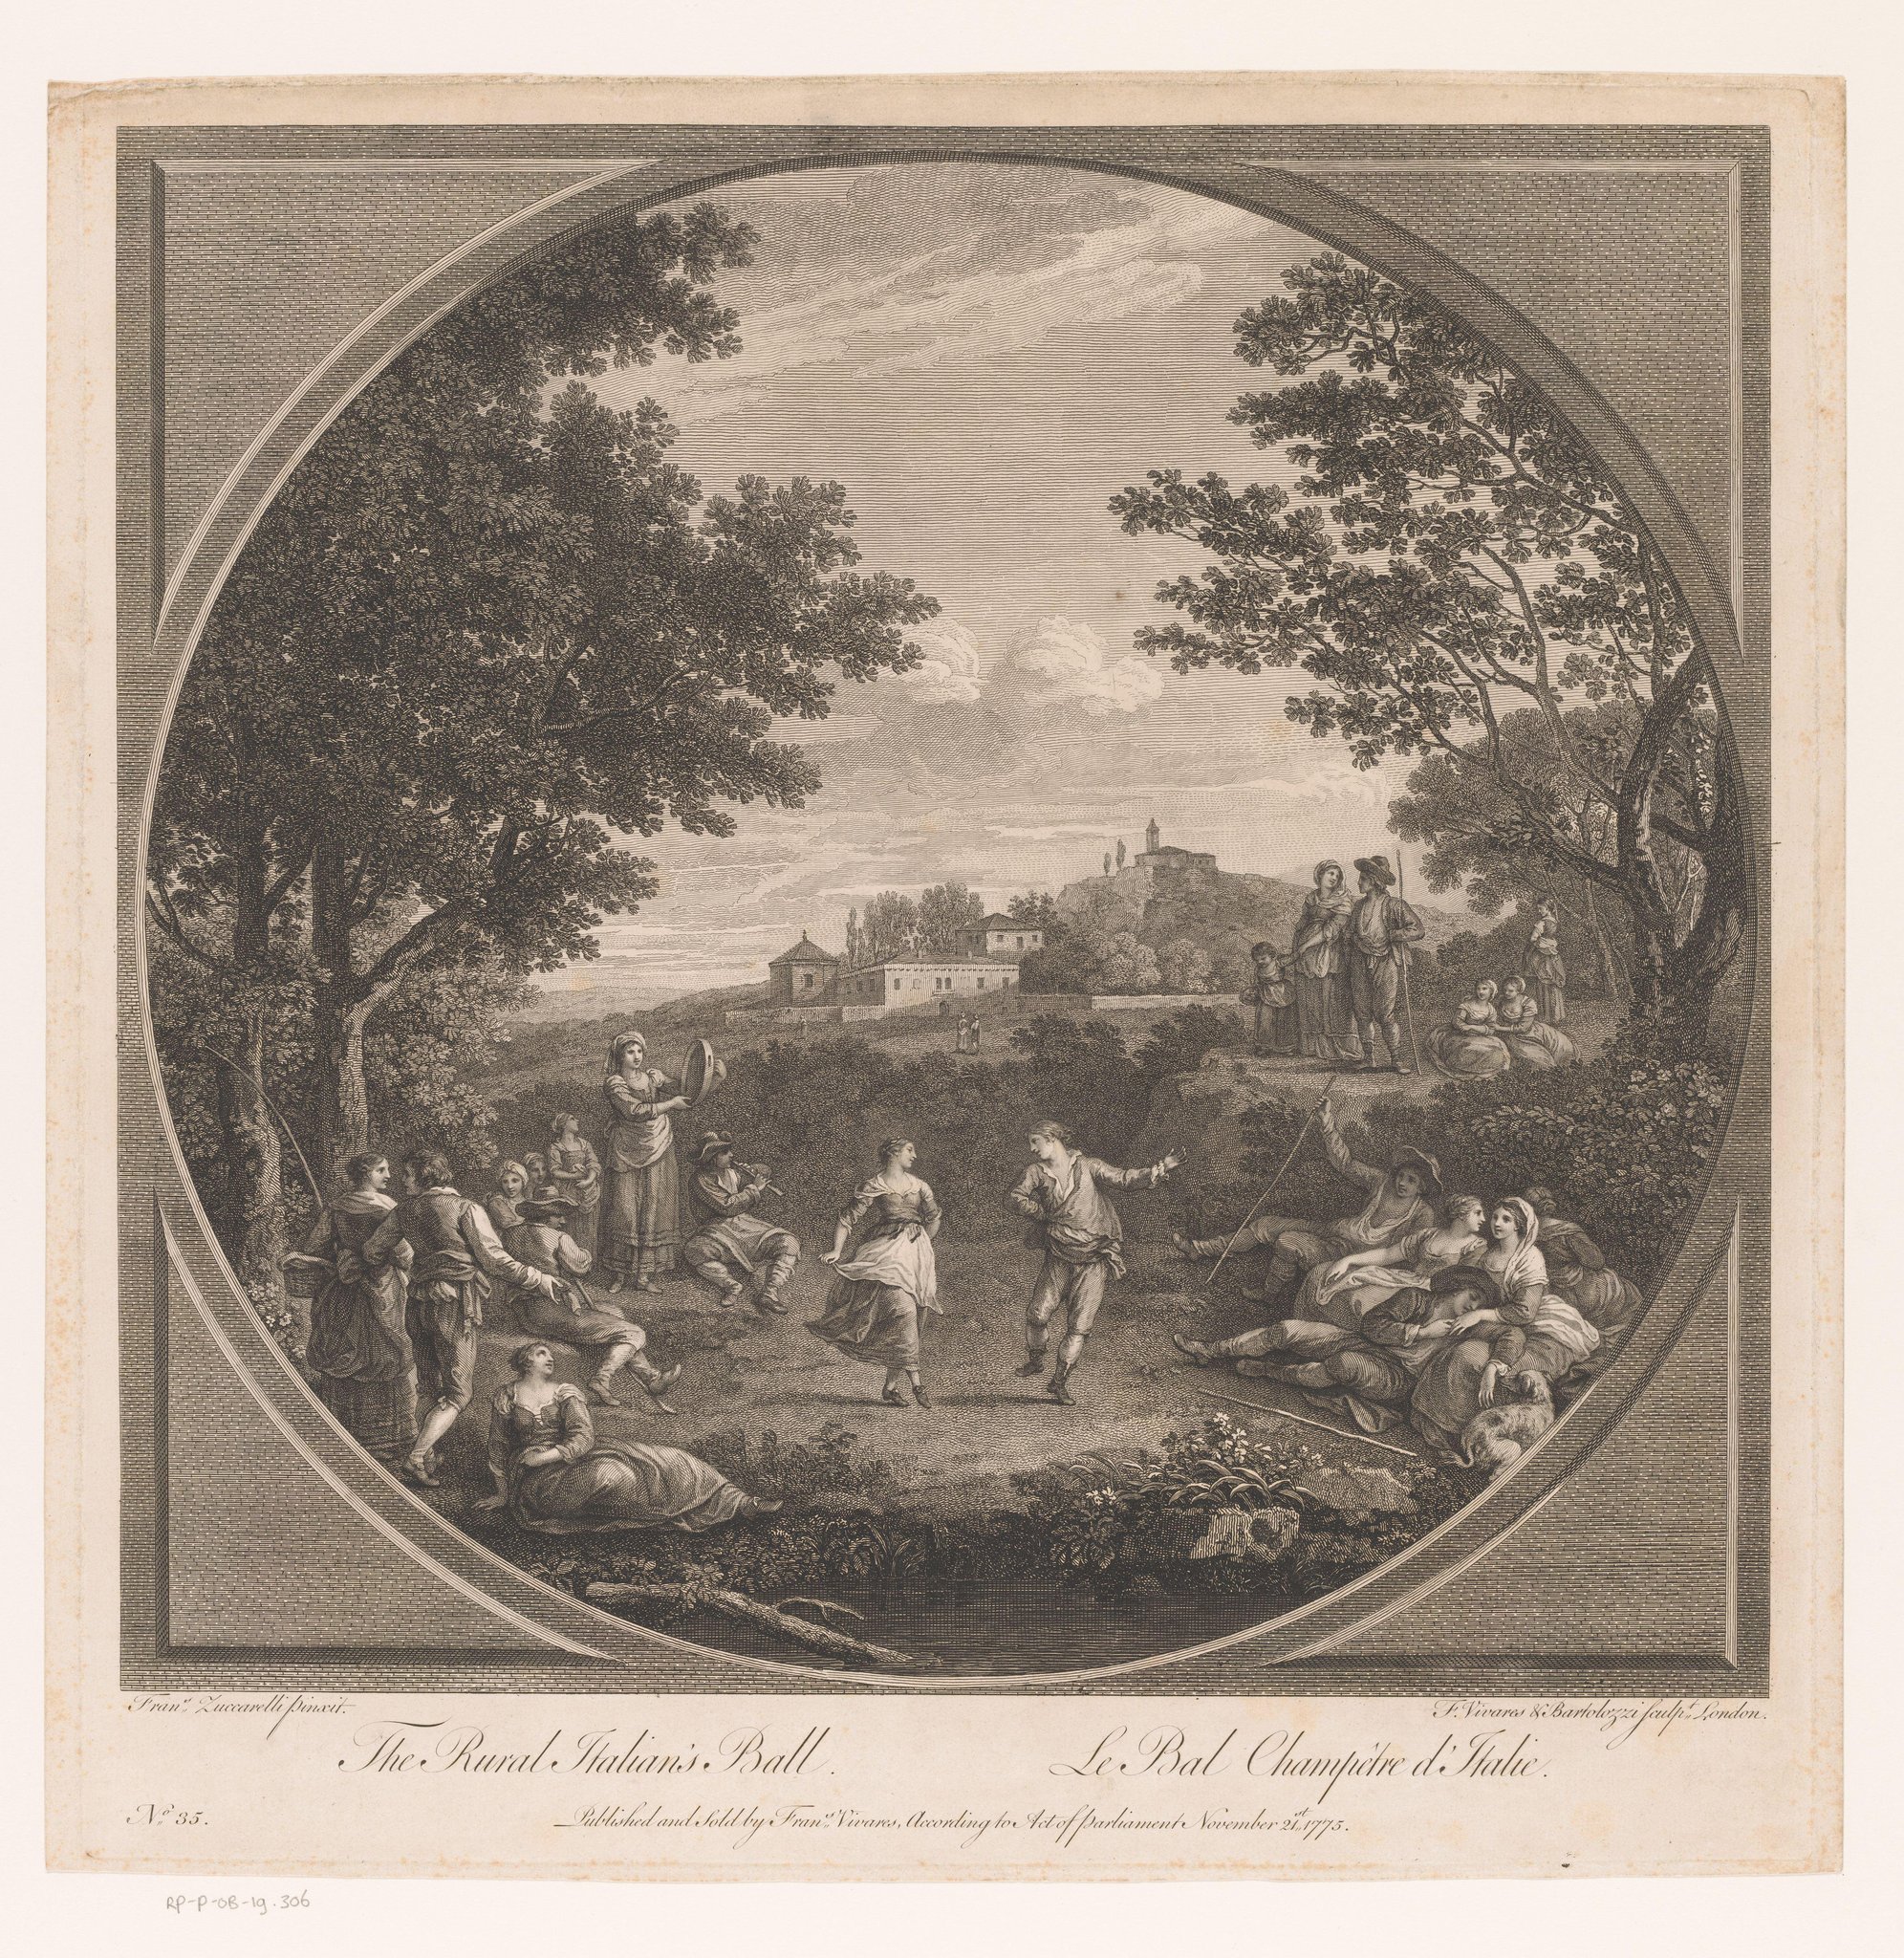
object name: print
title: Landschap met koppel dansend op muziek van fluit en tamboerijn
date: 1711-1775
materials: paper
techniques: etching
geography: london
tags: tambourine - cc - out of doors, herding, herdsman, herdswoman, shepherd, shepherdess, cowherd, etc., one pair dancing; man and woman dancing as a couple, flute, aulos, tibia - cc - out of doors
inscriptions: collector's mark: Lugt 2228